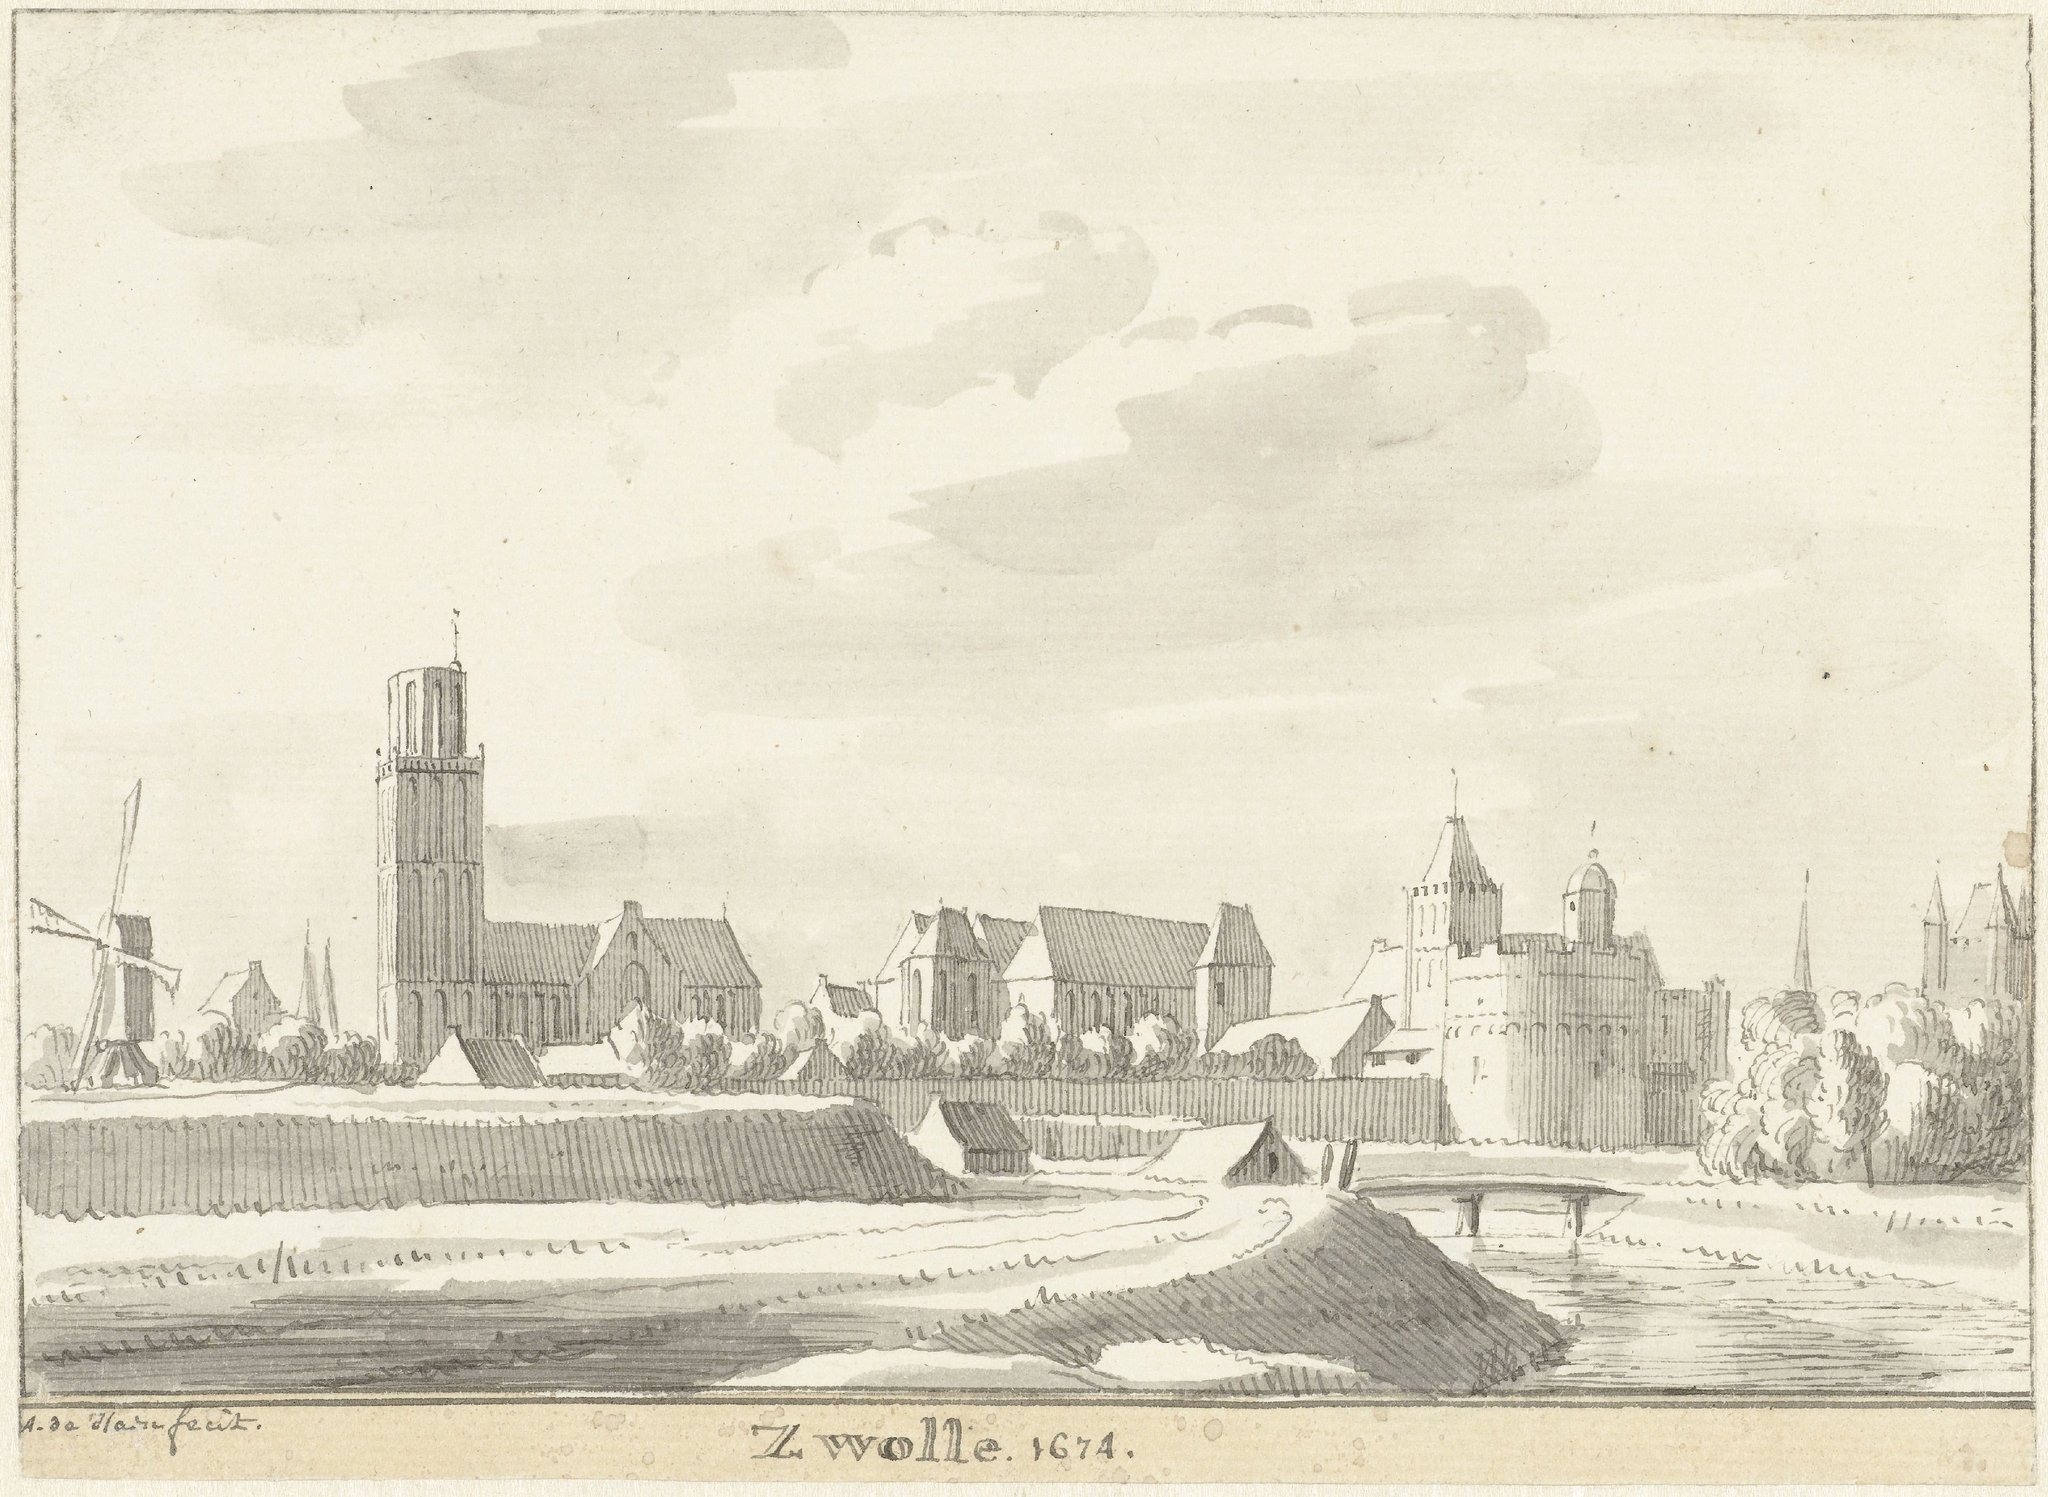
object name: drawing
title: Gezicht op Zwolle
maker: abraham de haen (ii)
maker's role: draughtsman, print maker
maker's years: 1707-1748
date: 1717-1748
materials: ink, paper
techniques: brush, pen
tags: prospect of city, town panorama, silhouette of city